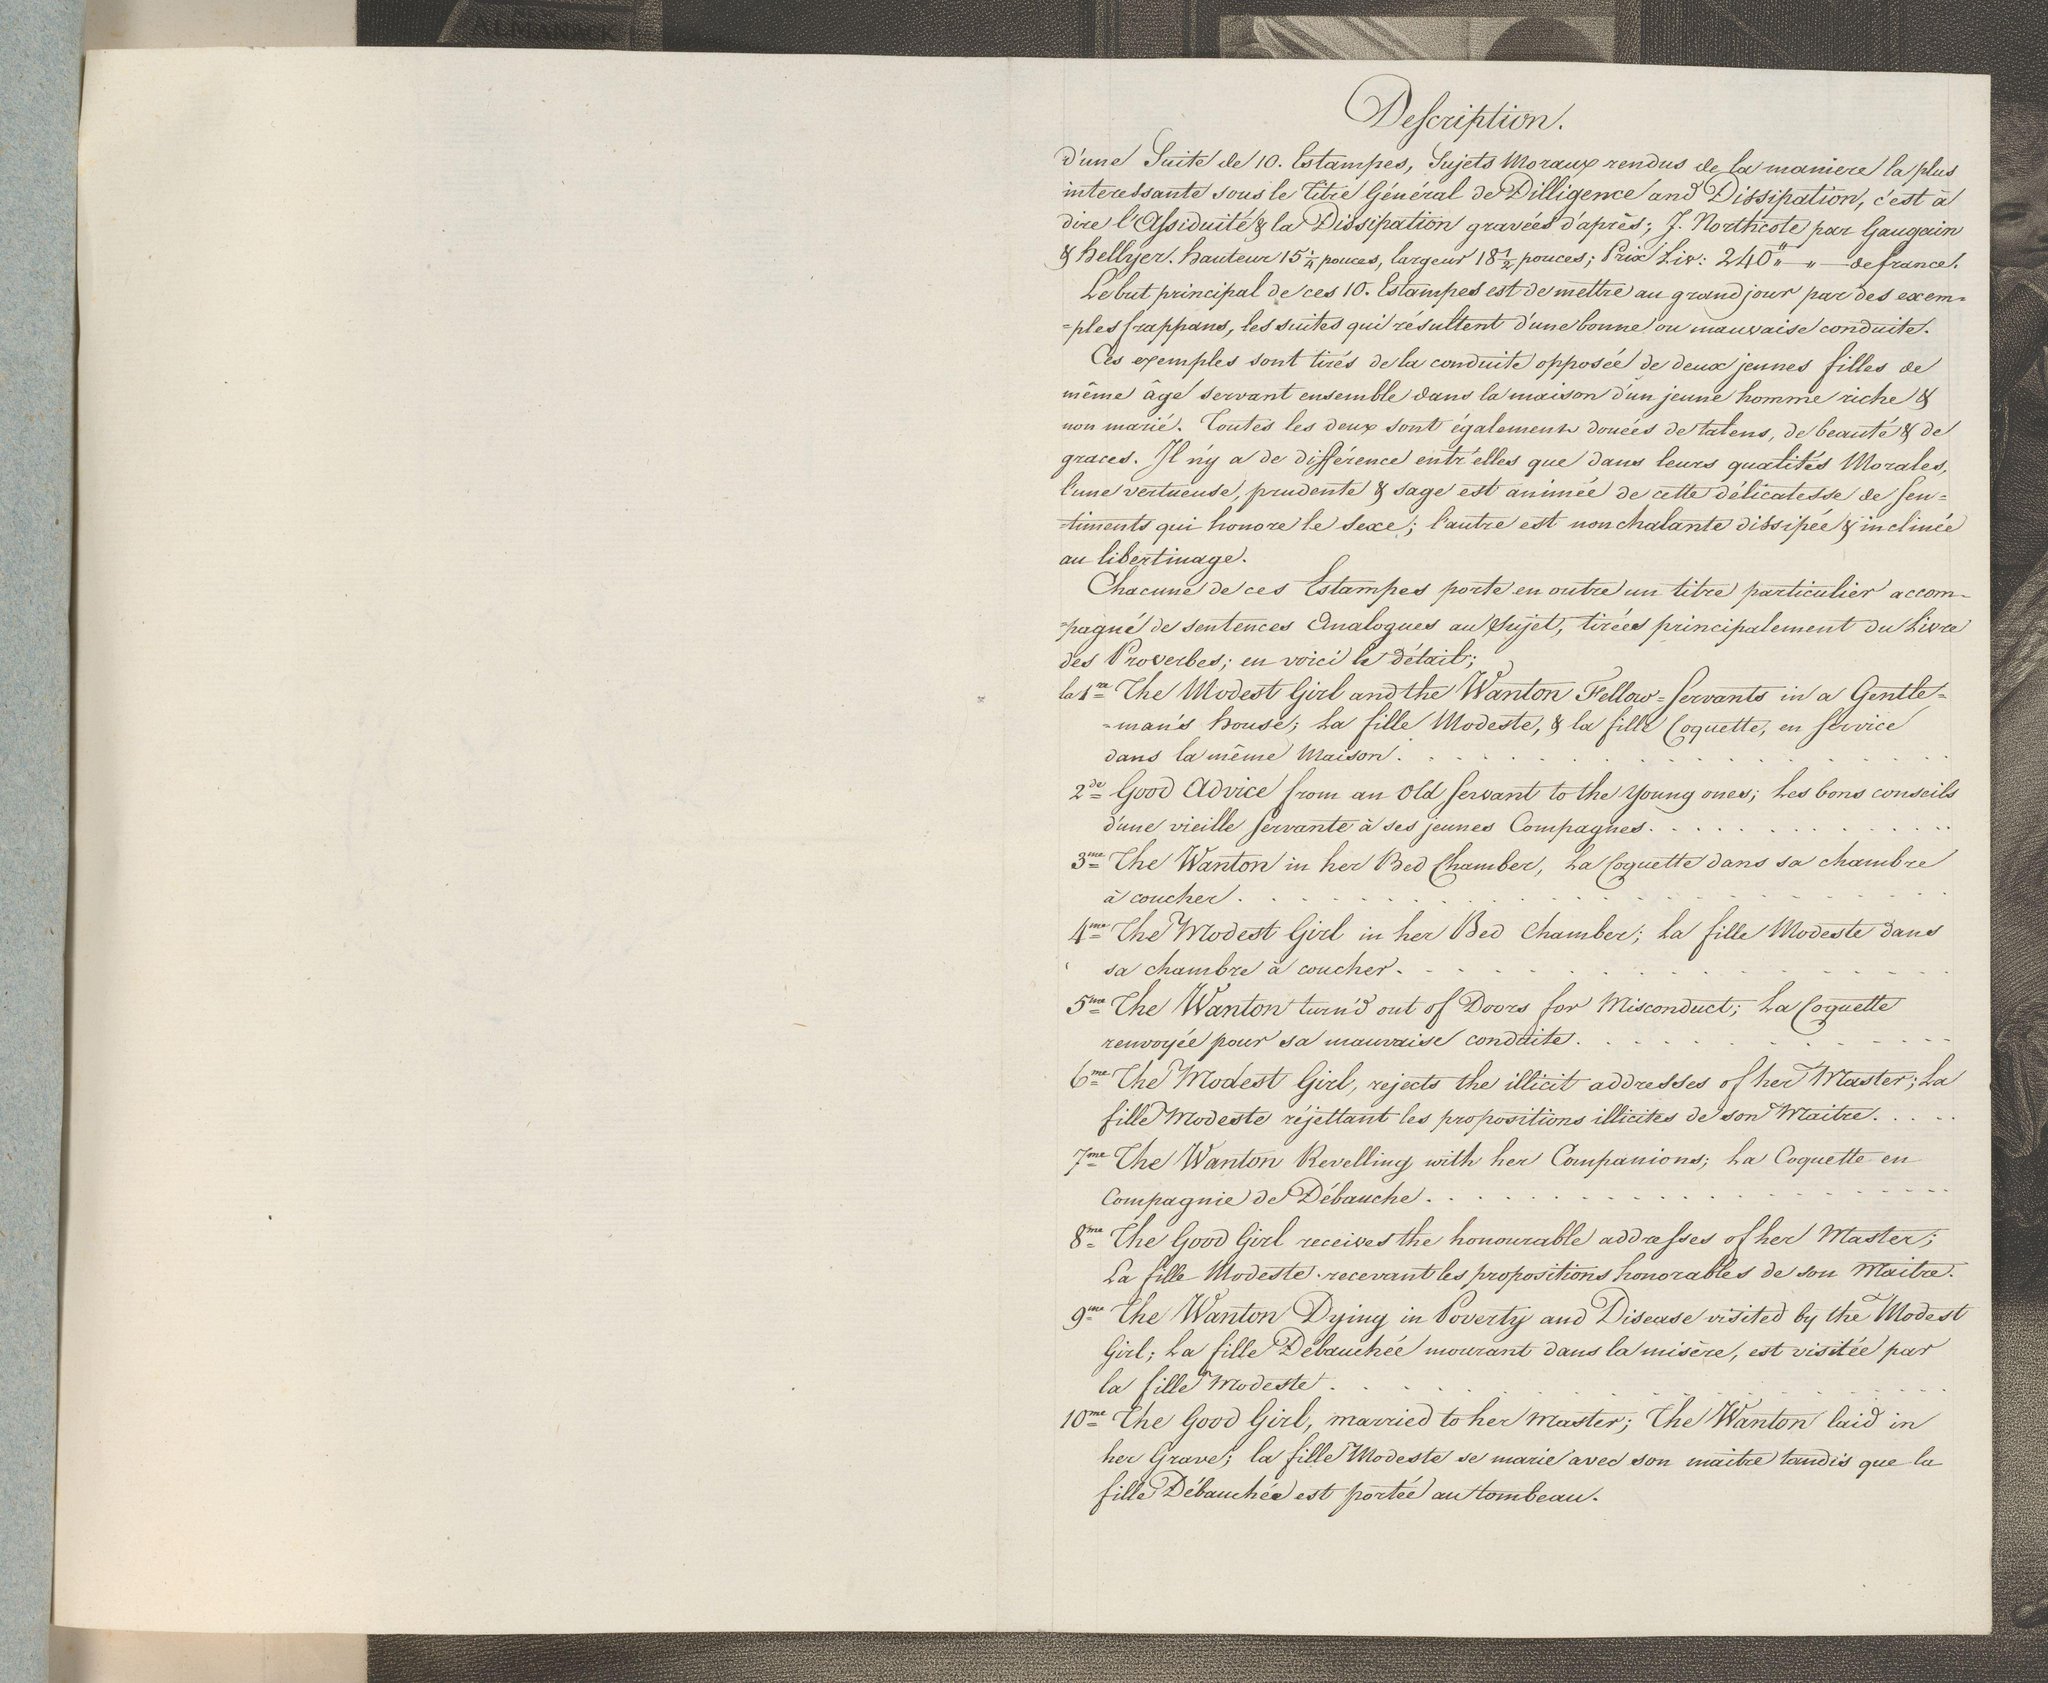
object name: text sheet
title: Deugzaamheid en losbandigheid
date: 1796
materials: ink, paper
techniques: writing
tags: good and bad behaviour, moral qualities (opposing concepts), proverbs, sayings, etc.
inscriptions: collector's mark: Lugt 2760, collector's mark: Lugt 2228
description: Inhoudsopgave in het Frans. Dit blad maakt deel uit van een album.